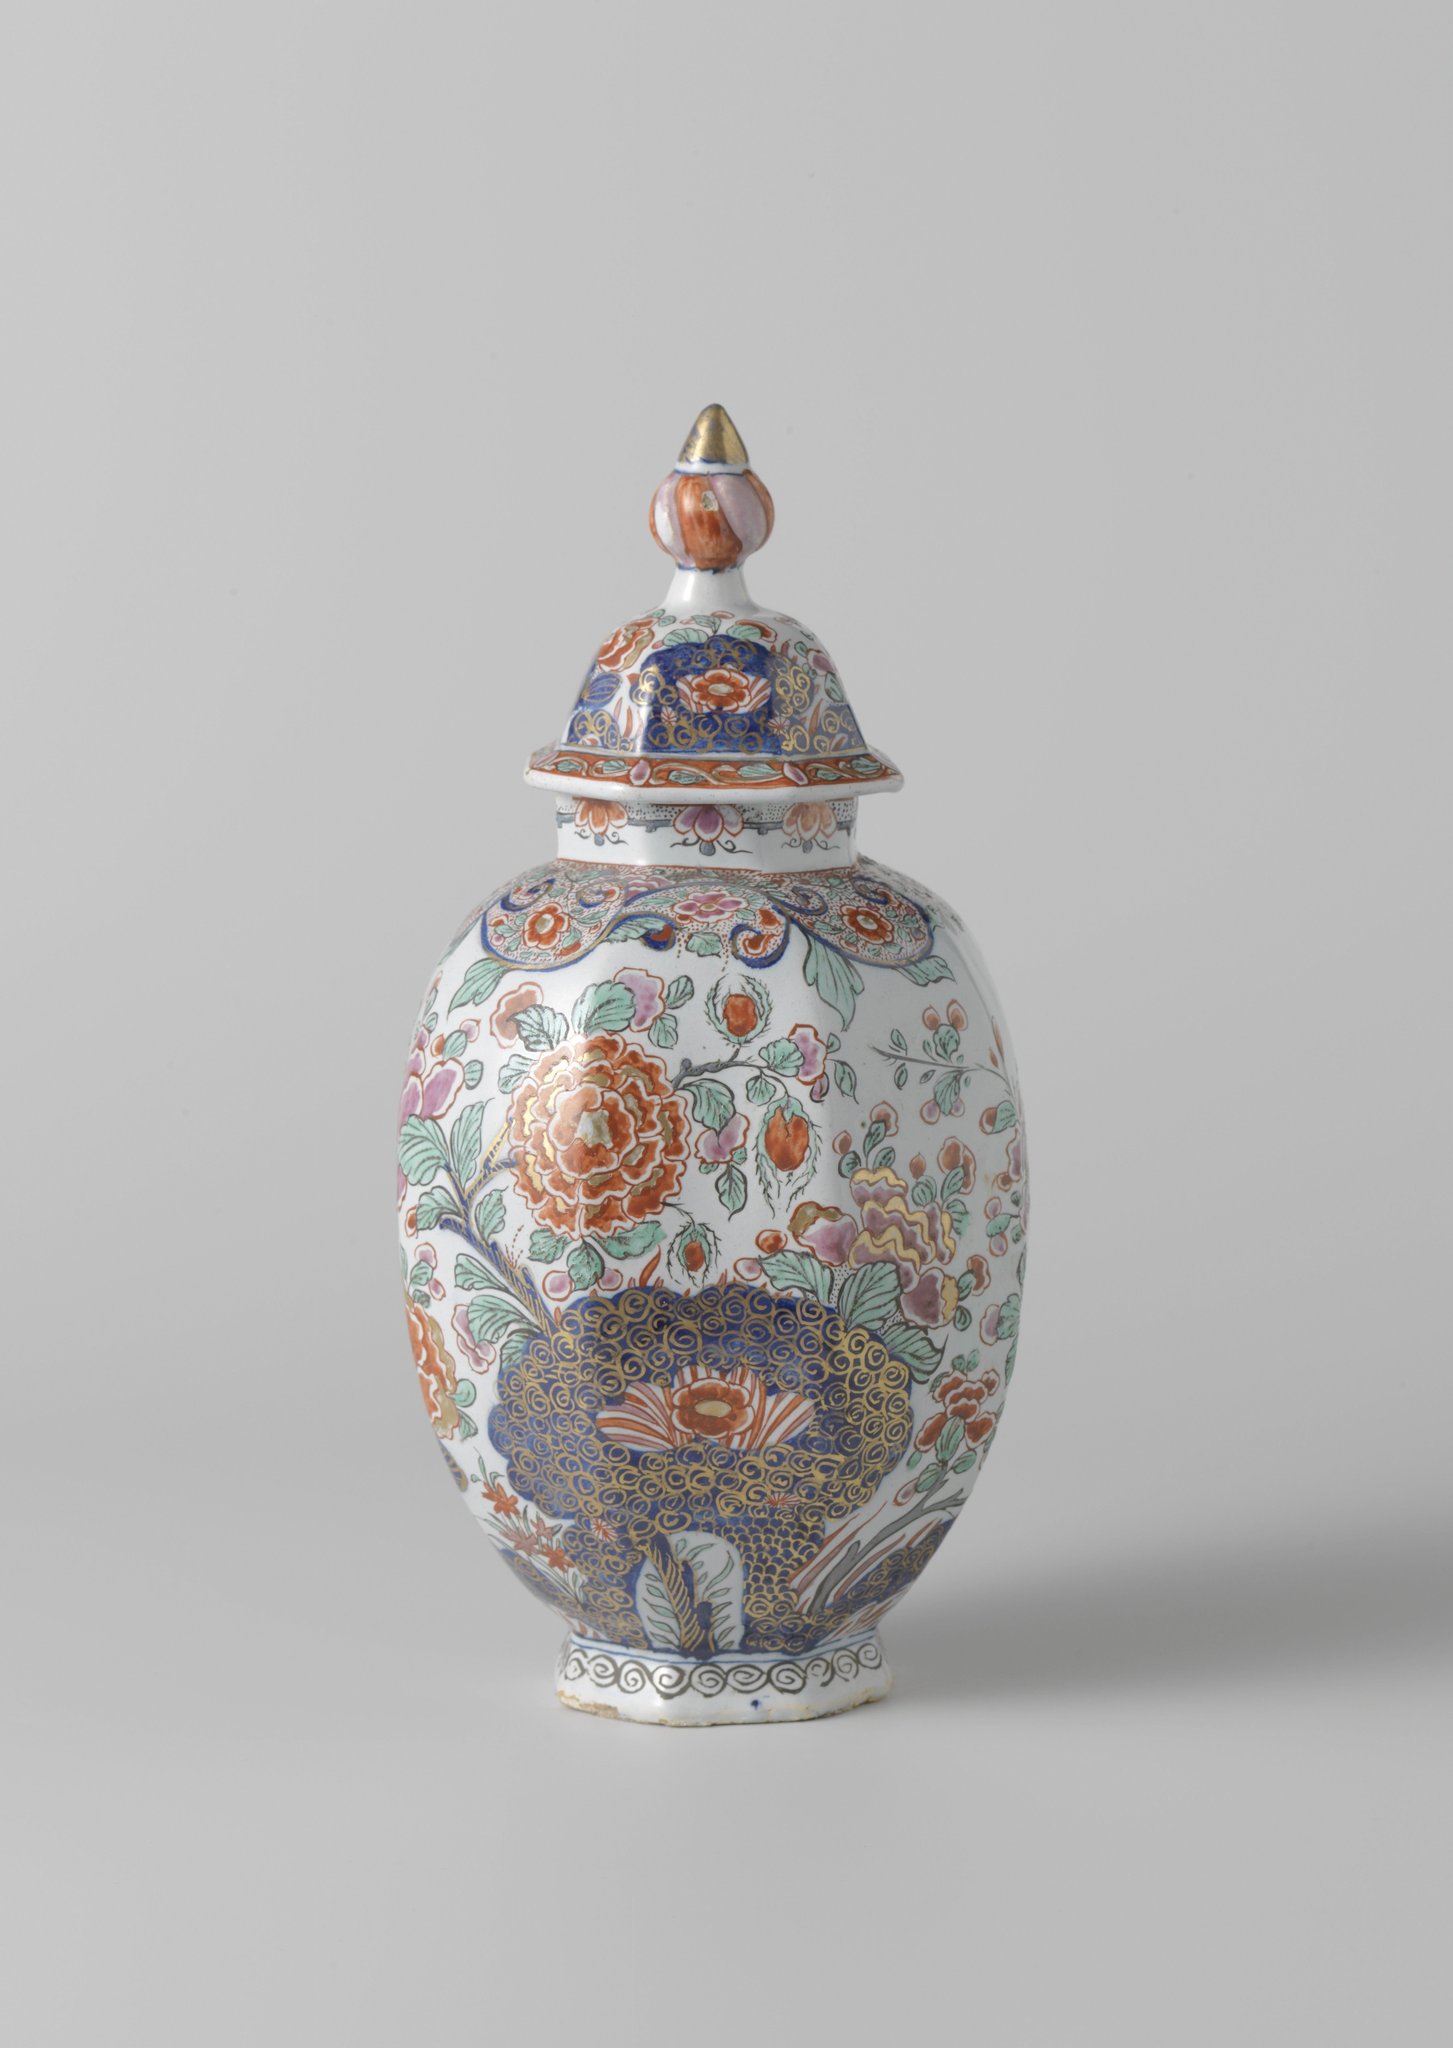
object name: covered jar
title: Deksel van een pot van veelkleurig beschilderd faïence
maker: Anonymous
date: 1730-1760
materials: faience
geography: delft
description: Deksel van pot veelkleurig beschilderde faïence. Veelkleurig beschilderd met bloemdecoraties. De pot is een onderdeel van een kaststel.